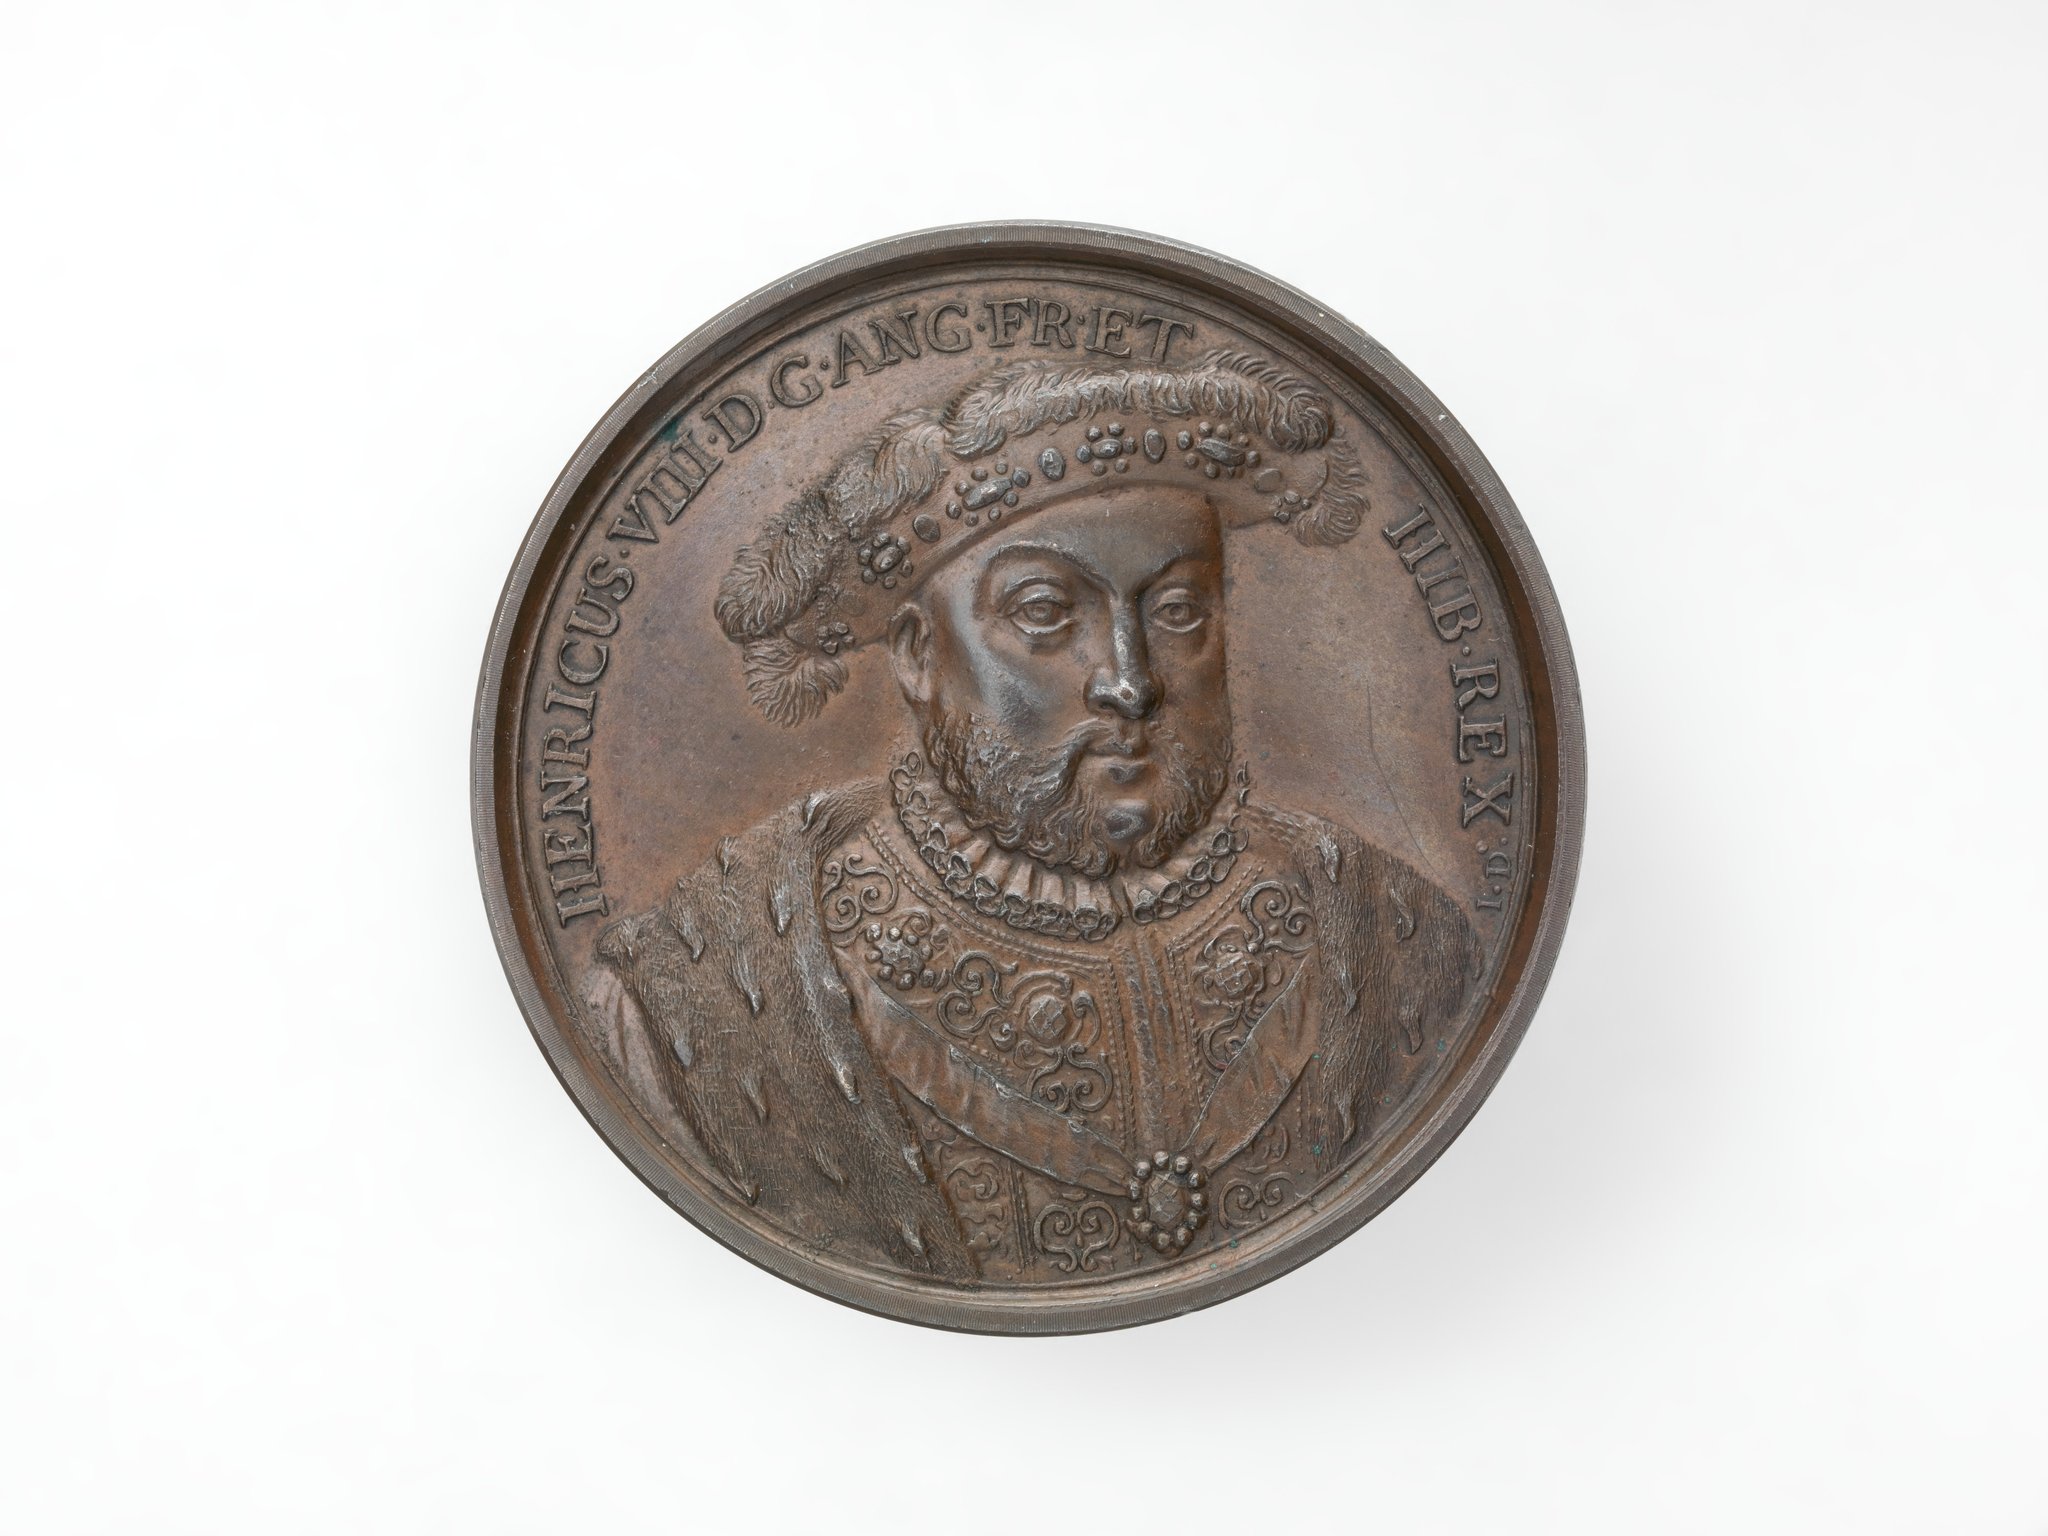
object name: medal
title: Henry VIII, from the English Monarchs series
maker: jean dassier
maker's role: artist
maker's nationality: swiss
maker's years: 1676-1763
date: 1731-1732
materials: bronze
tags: henry viii,portraits